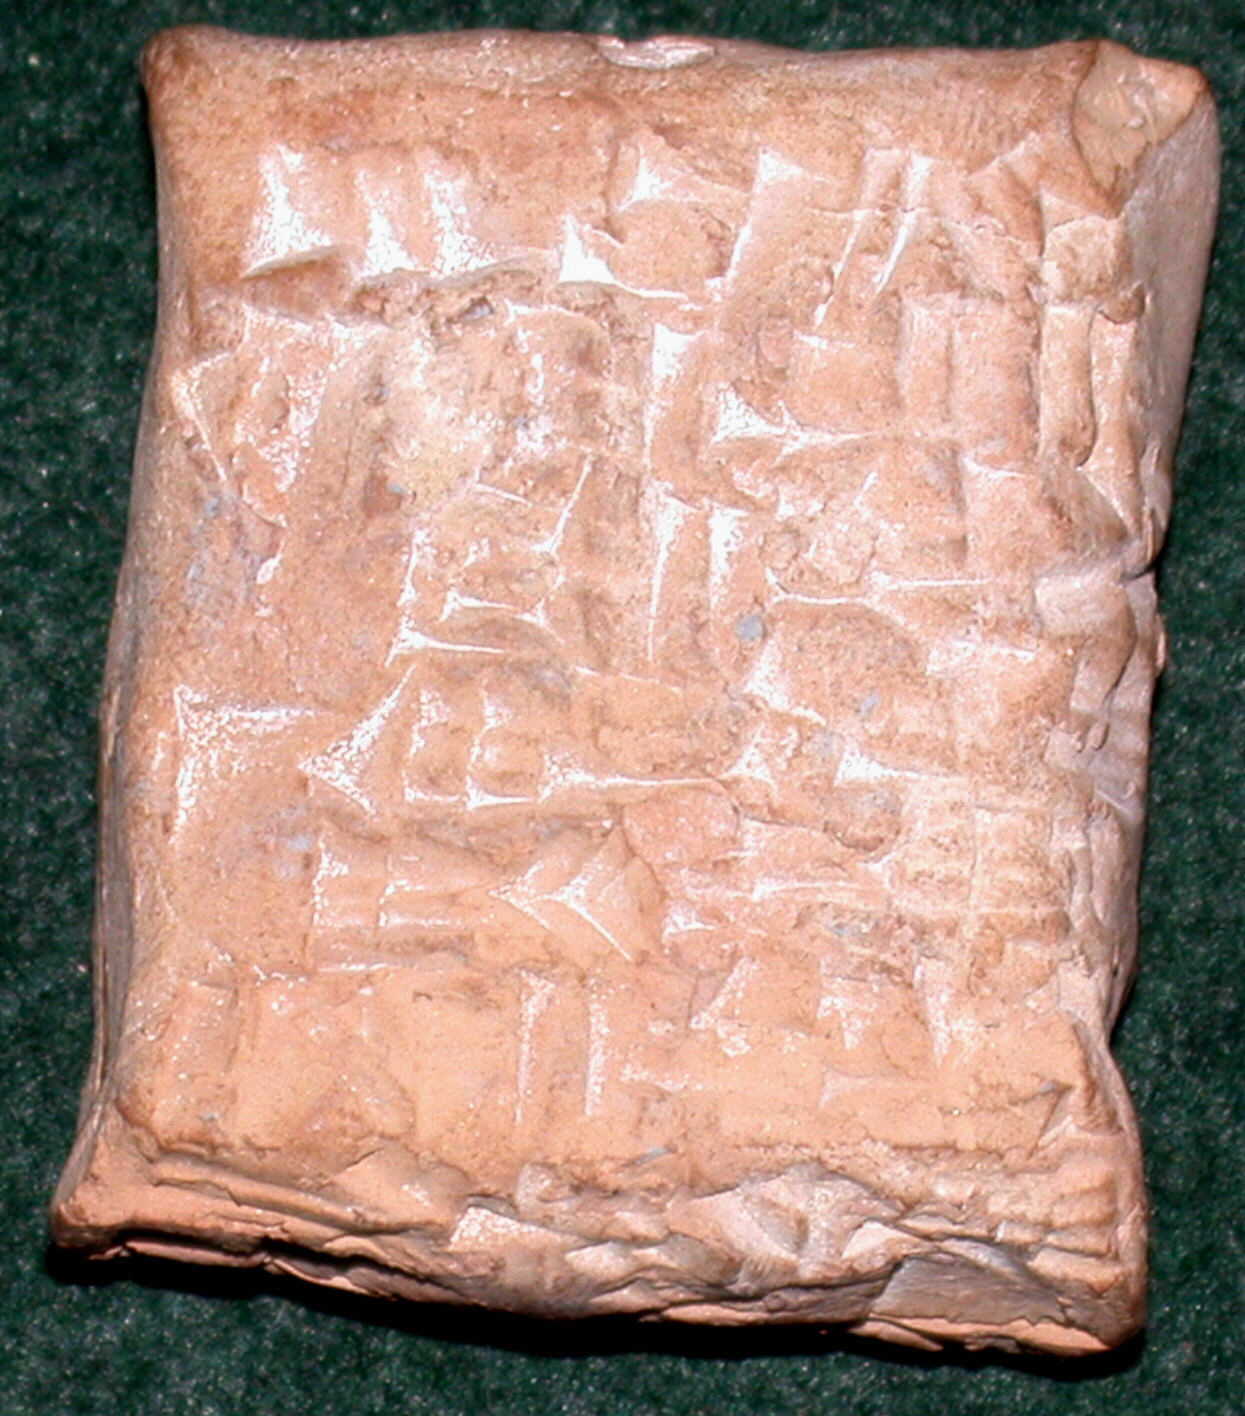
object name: cuneiform tablet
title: Cuneiform tablet: field rental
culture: babylonian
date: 1749-1712 BCE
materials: clay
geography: mesopotamia